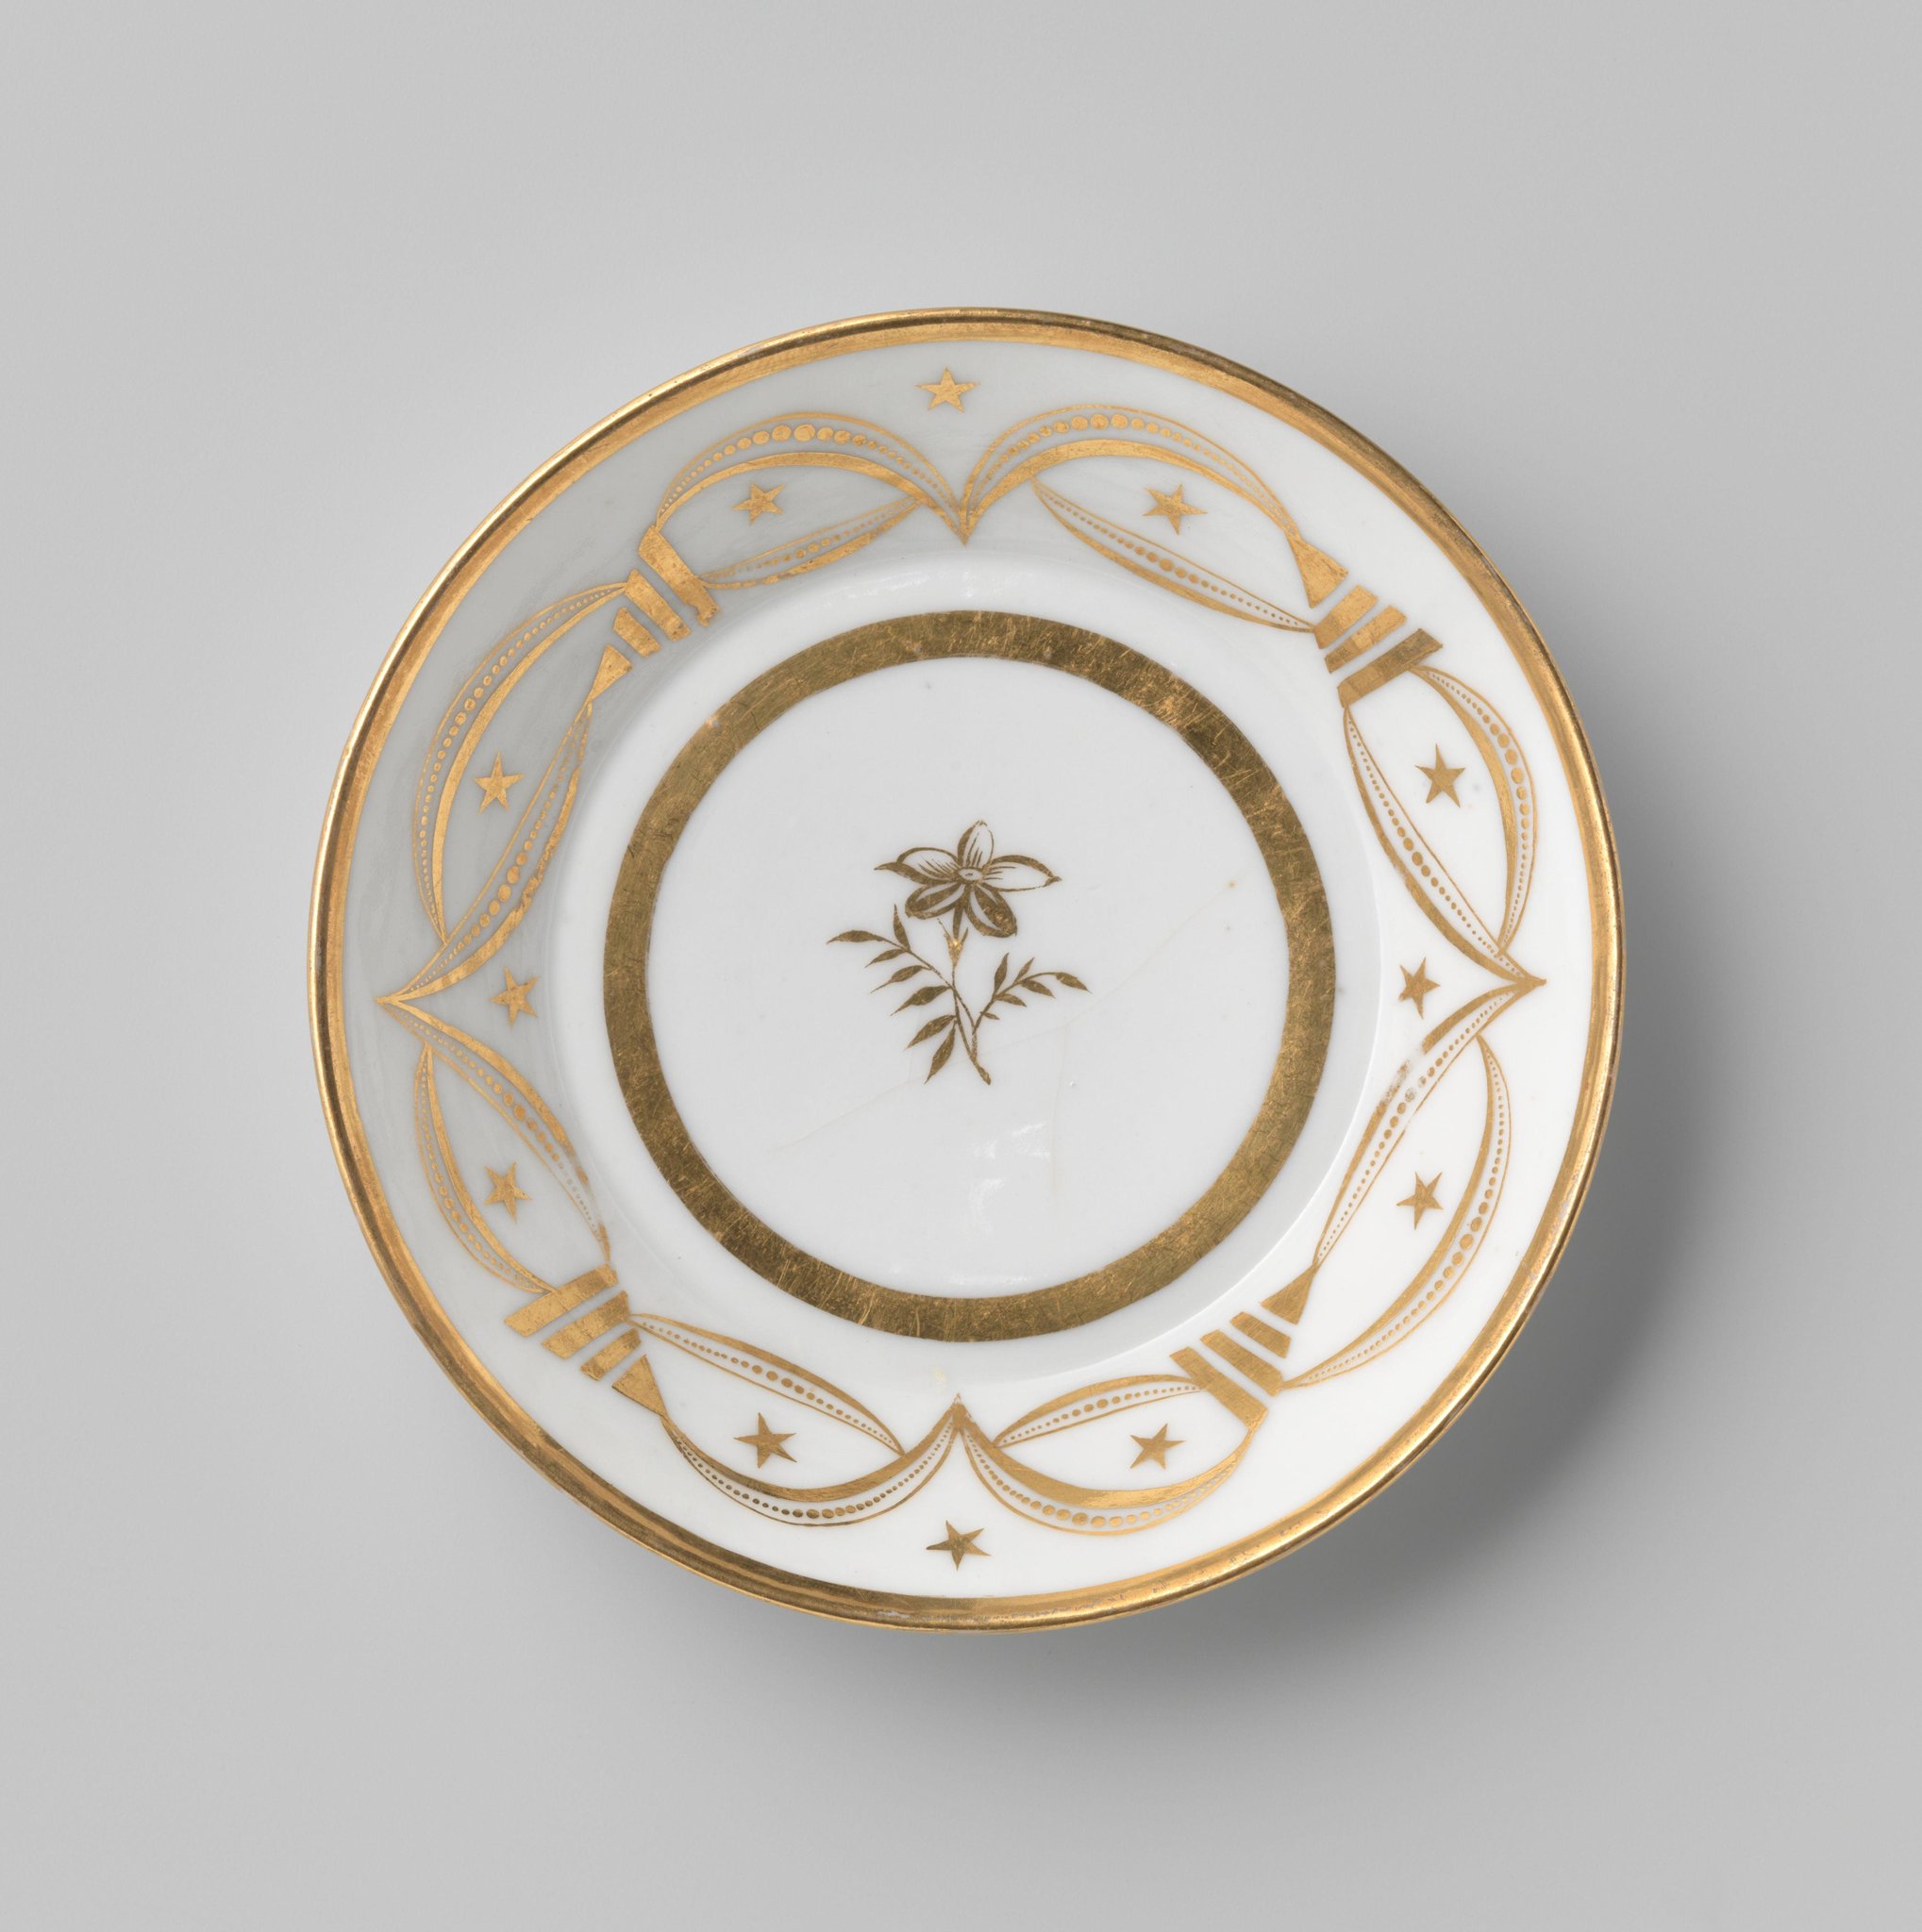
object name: service set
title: Saucer with an ornamental border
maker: Anonymous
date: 1800-1824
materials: glaze, gold, paint, porcelain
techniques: firing, forming, gilding, turning, vitrification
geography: france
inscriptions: mark: ‘g’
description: Schotel van porselein, versierd met gouden banden waartussen een slingermotief dat wordt gevormd door halvemaanvormige schijven waarin punten. De schijven worden verbonden door driehoeken. Op de tussenliggende velden gouden sterren. Op het plat een bloemtak. Behoort tot een serie van twaalf kop-en-schotels (BK-16044-F-1-24), onderdeel van een koffie- en theeservies.